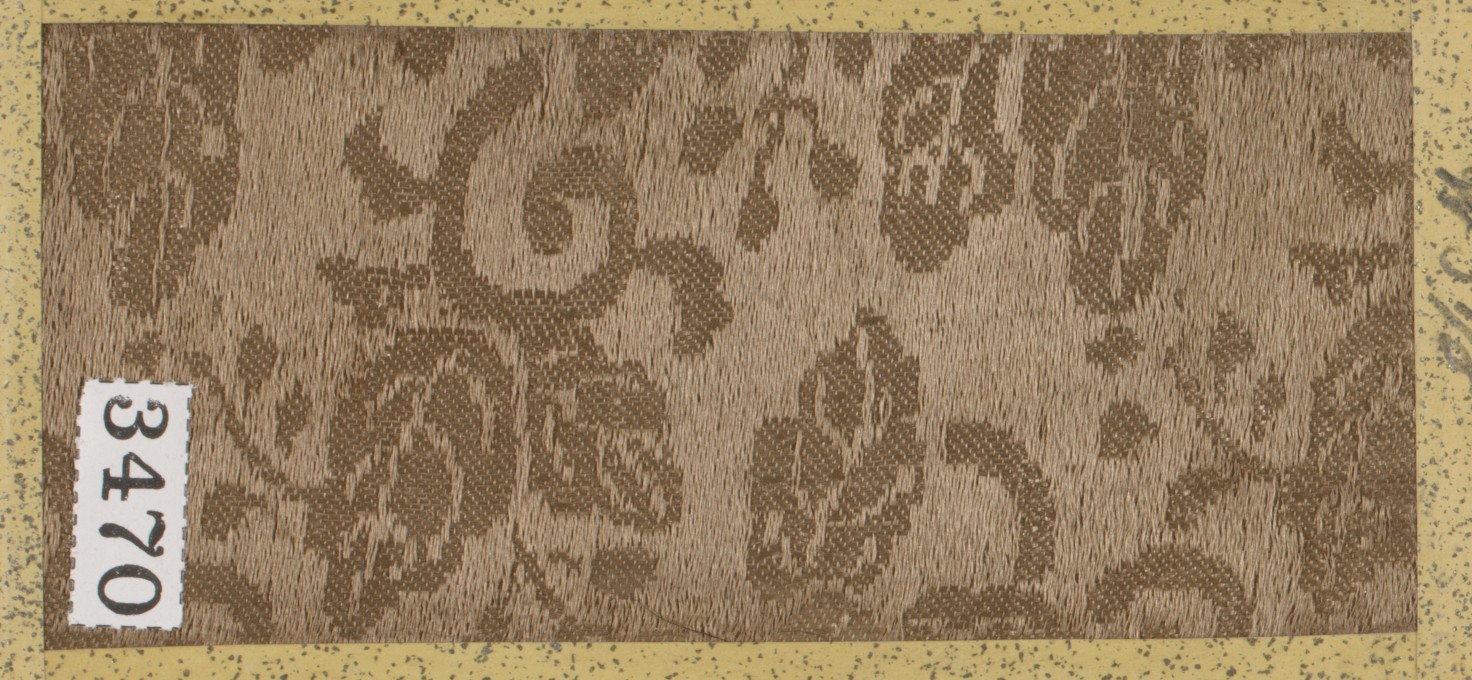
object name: sample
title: Textile Sample from Sample Book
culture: japanese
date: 1801-1900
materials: silk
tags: leaves